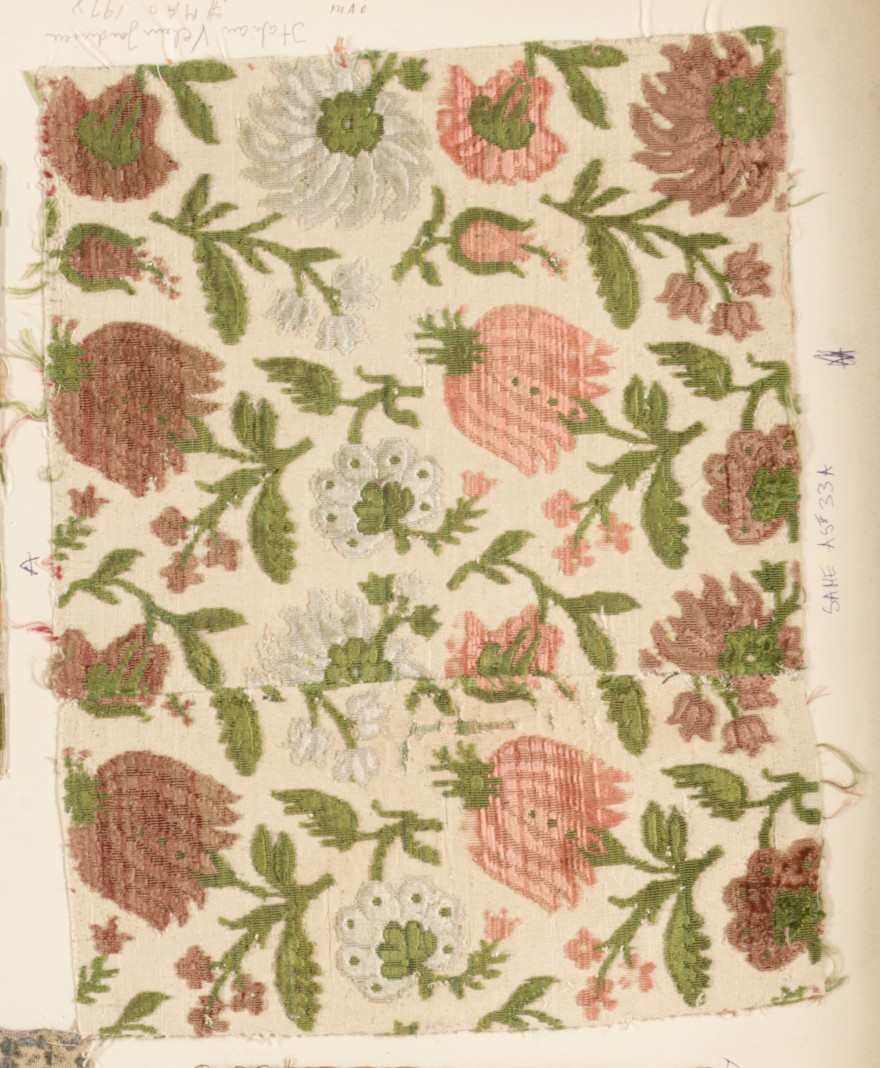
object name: fragment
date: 1601-1700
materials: silk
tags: flowers,leaves